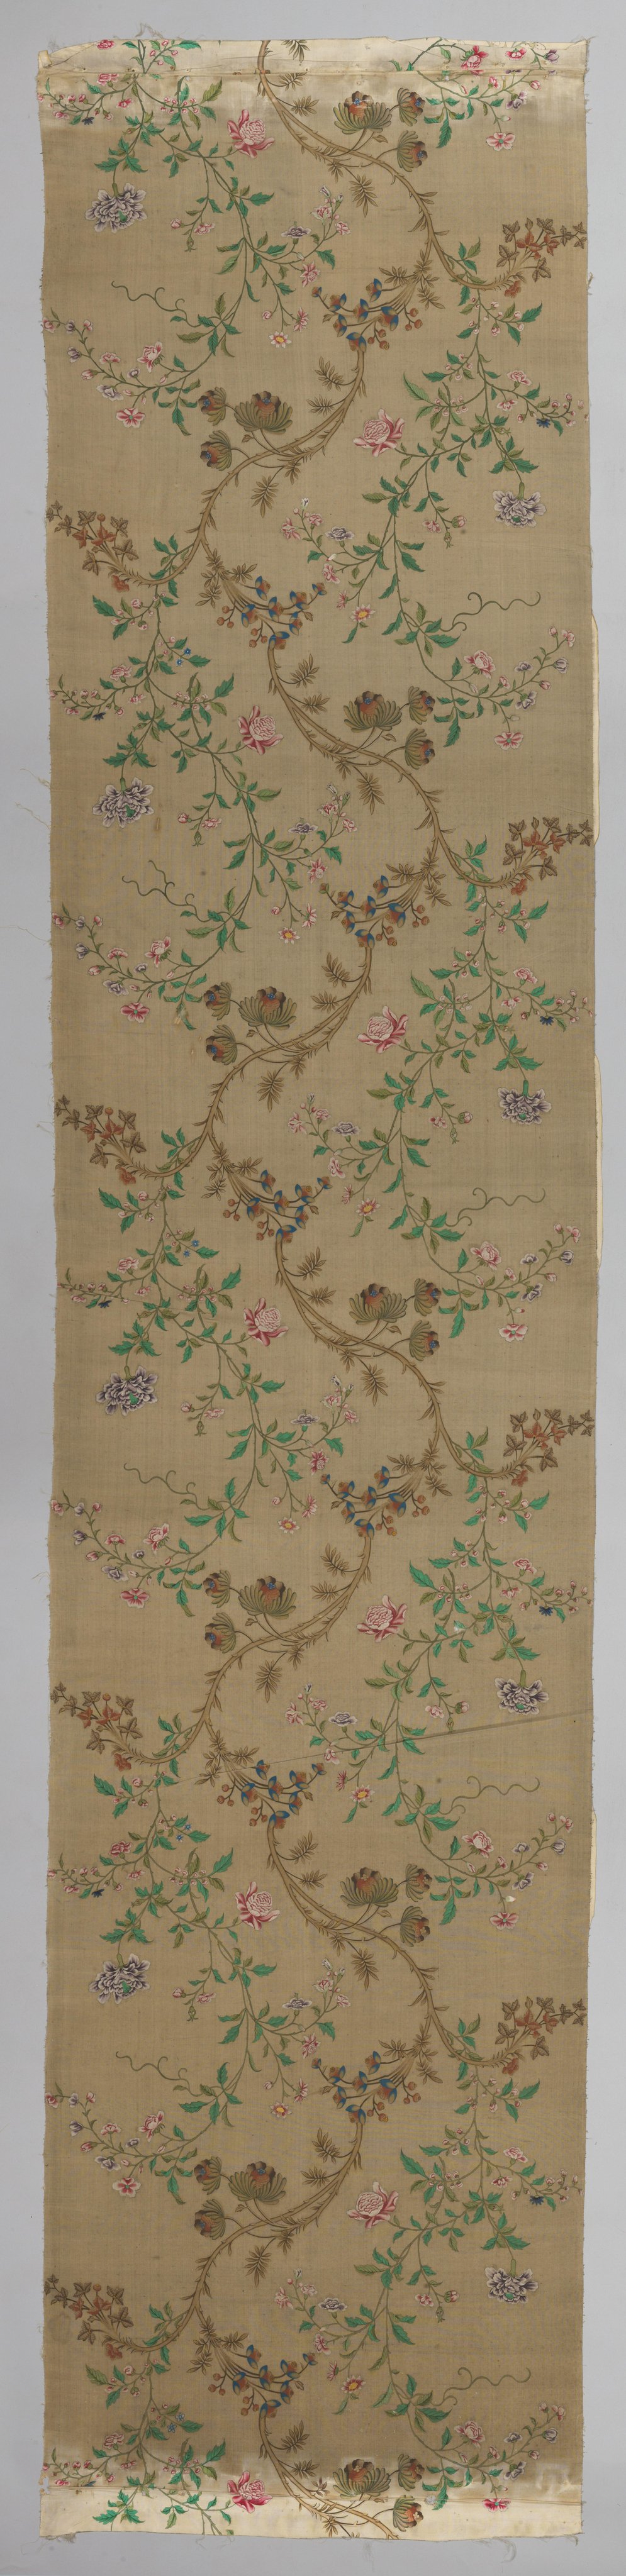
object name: interieuronderdeel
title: Bespanningsstof met decor van takken, bladeren, bloemen en vruchten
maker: Anonymous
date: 1750-1790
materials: paint, silk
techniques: printing, weave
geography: china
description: Een baan veelkleurig beschilderde creme bespanningsstof van zijde.